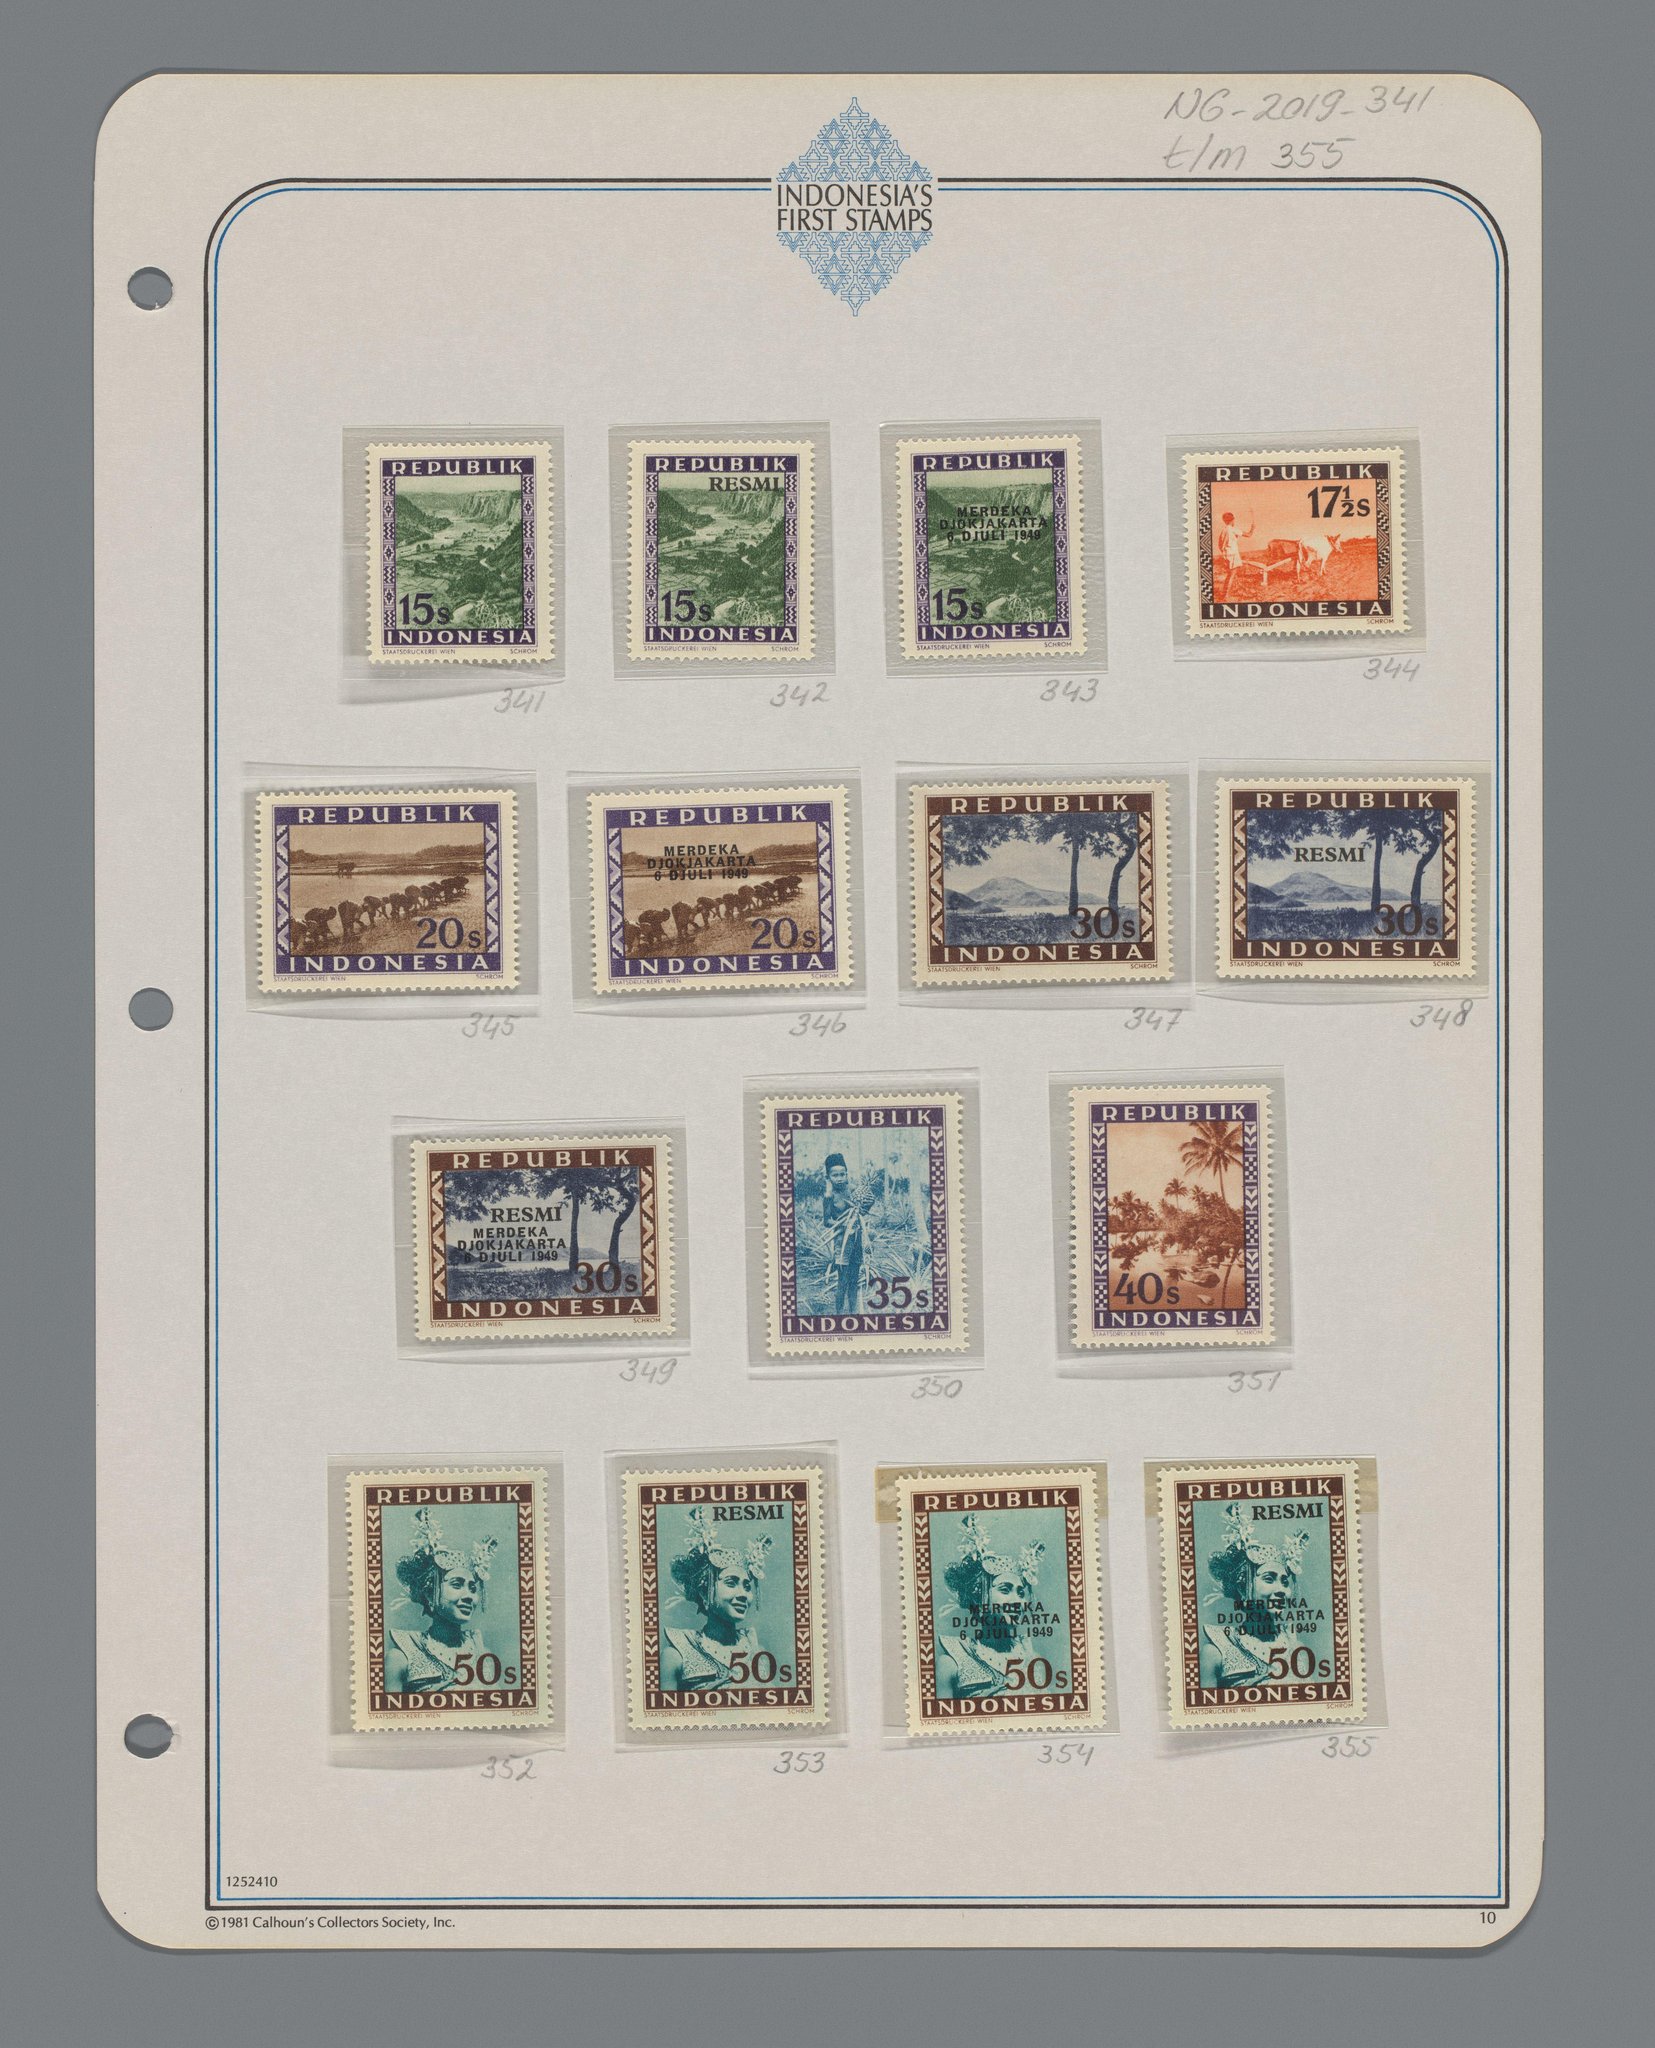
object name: postage stamp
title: Postzegel Republik Indonesia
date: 1949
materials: paper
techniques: photoaquatint, engraving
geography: vienna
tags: indonesia